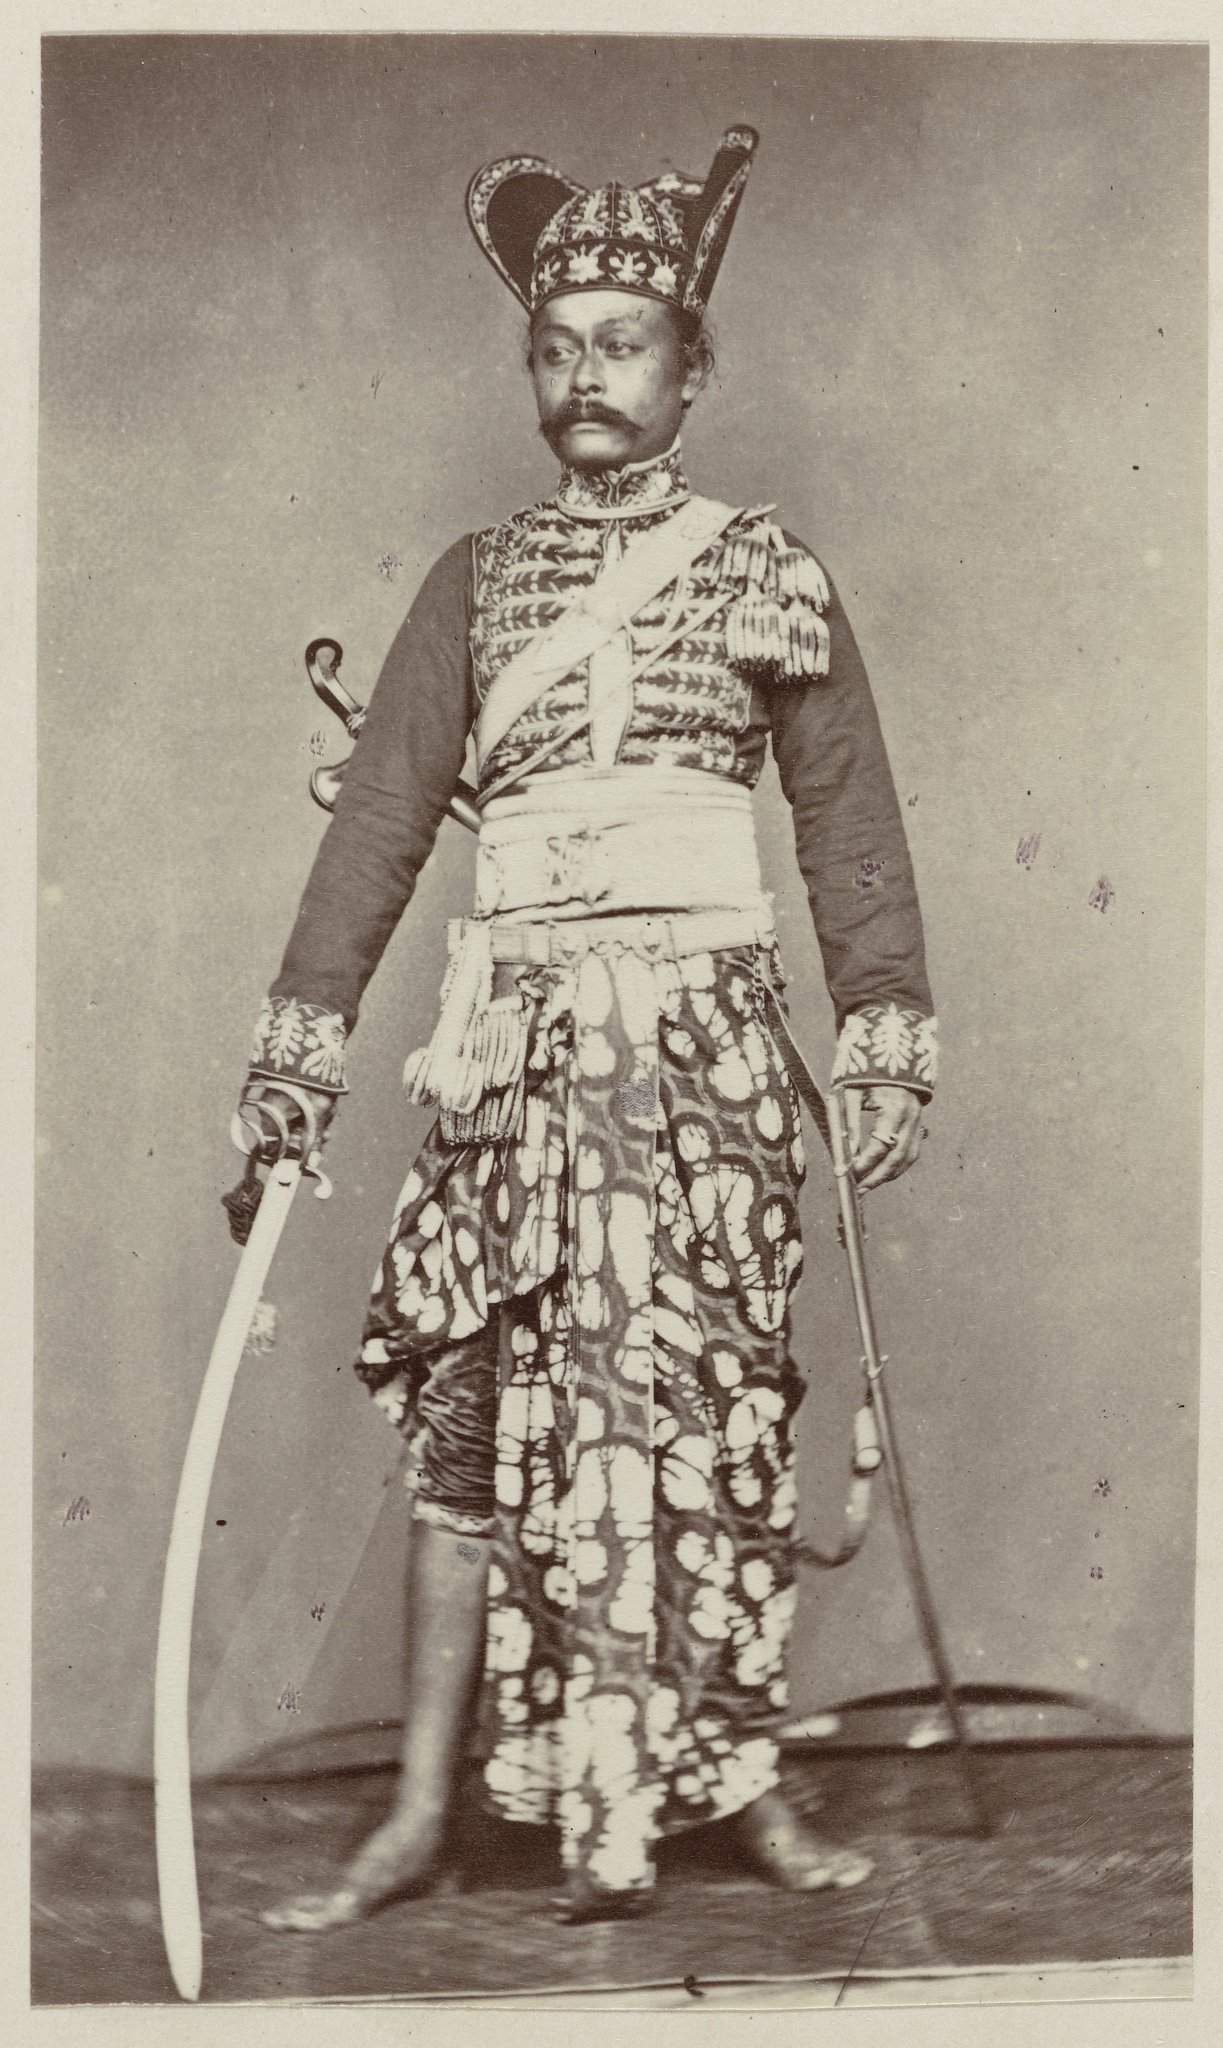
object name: photograph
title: Portrait of an Indigenous Prince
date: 1860-1870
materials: photographic support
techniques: albumen print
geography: batavia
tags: historical persons not known by name, java, batavia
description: Studioportret van een inlandse vorst, staand met ontbloot sabel. Ingeplakte foto in het fotoalbum getiteld: Gezichten van Java.